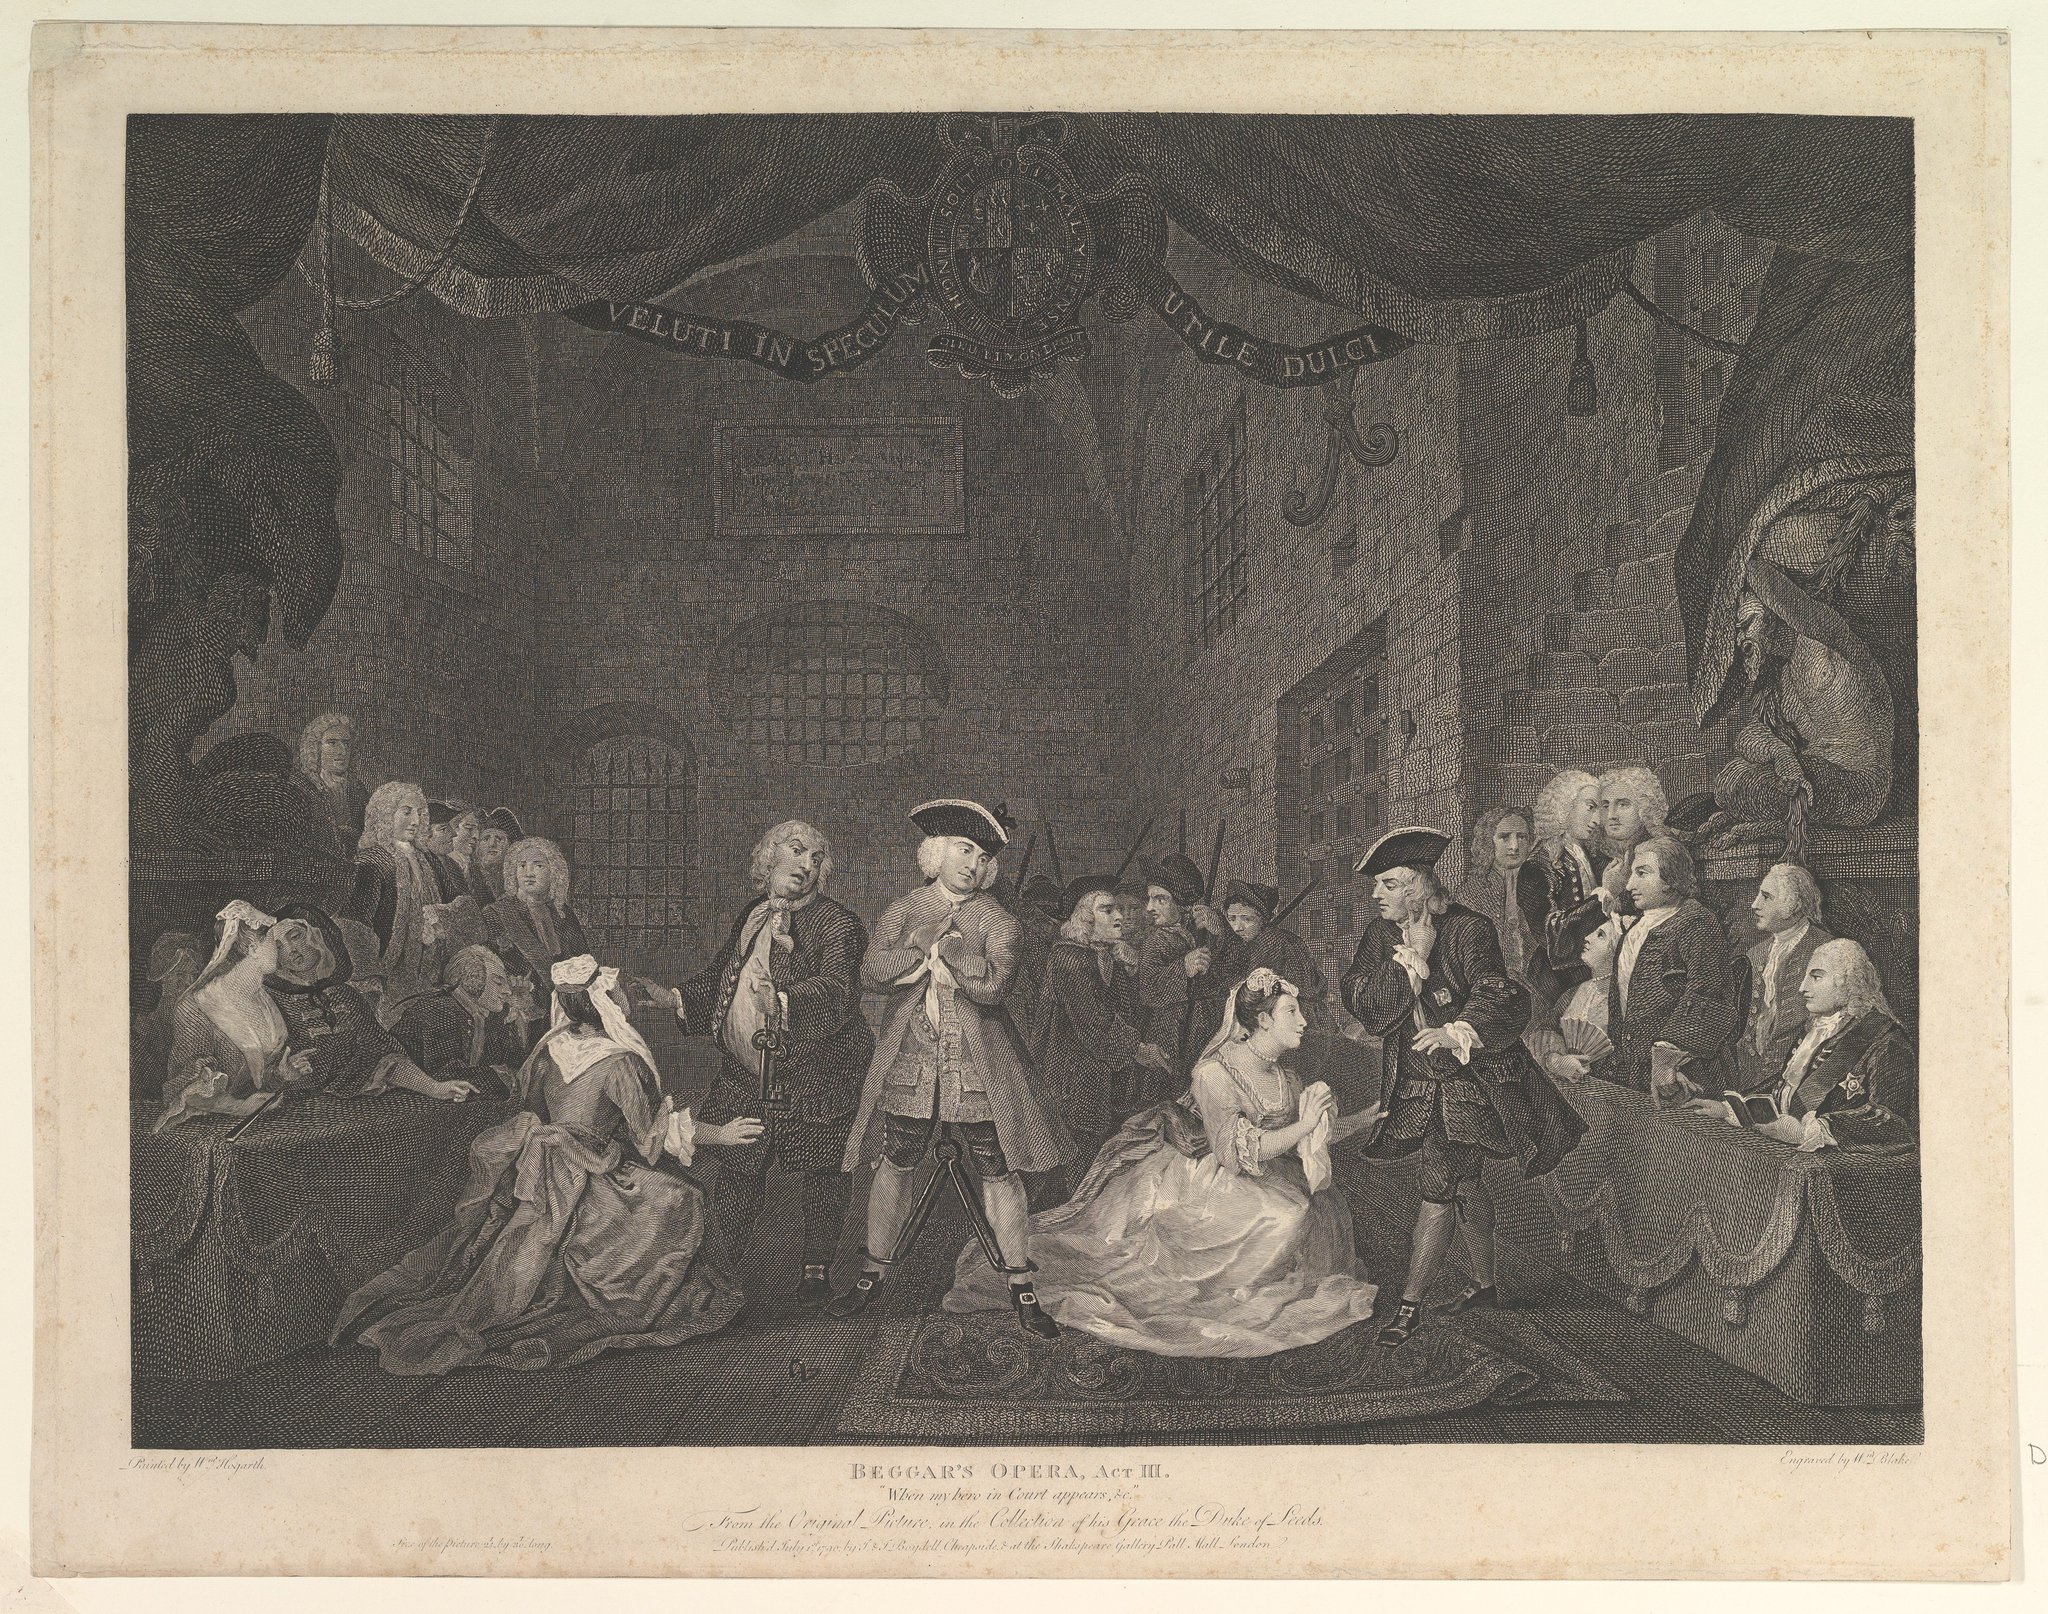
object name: print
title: The Beggar's Opera, Act III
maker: william blake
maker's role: artist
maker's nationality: british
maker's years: 1757-1827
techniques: engraving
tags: opera,men,women,spectators,coat of arms